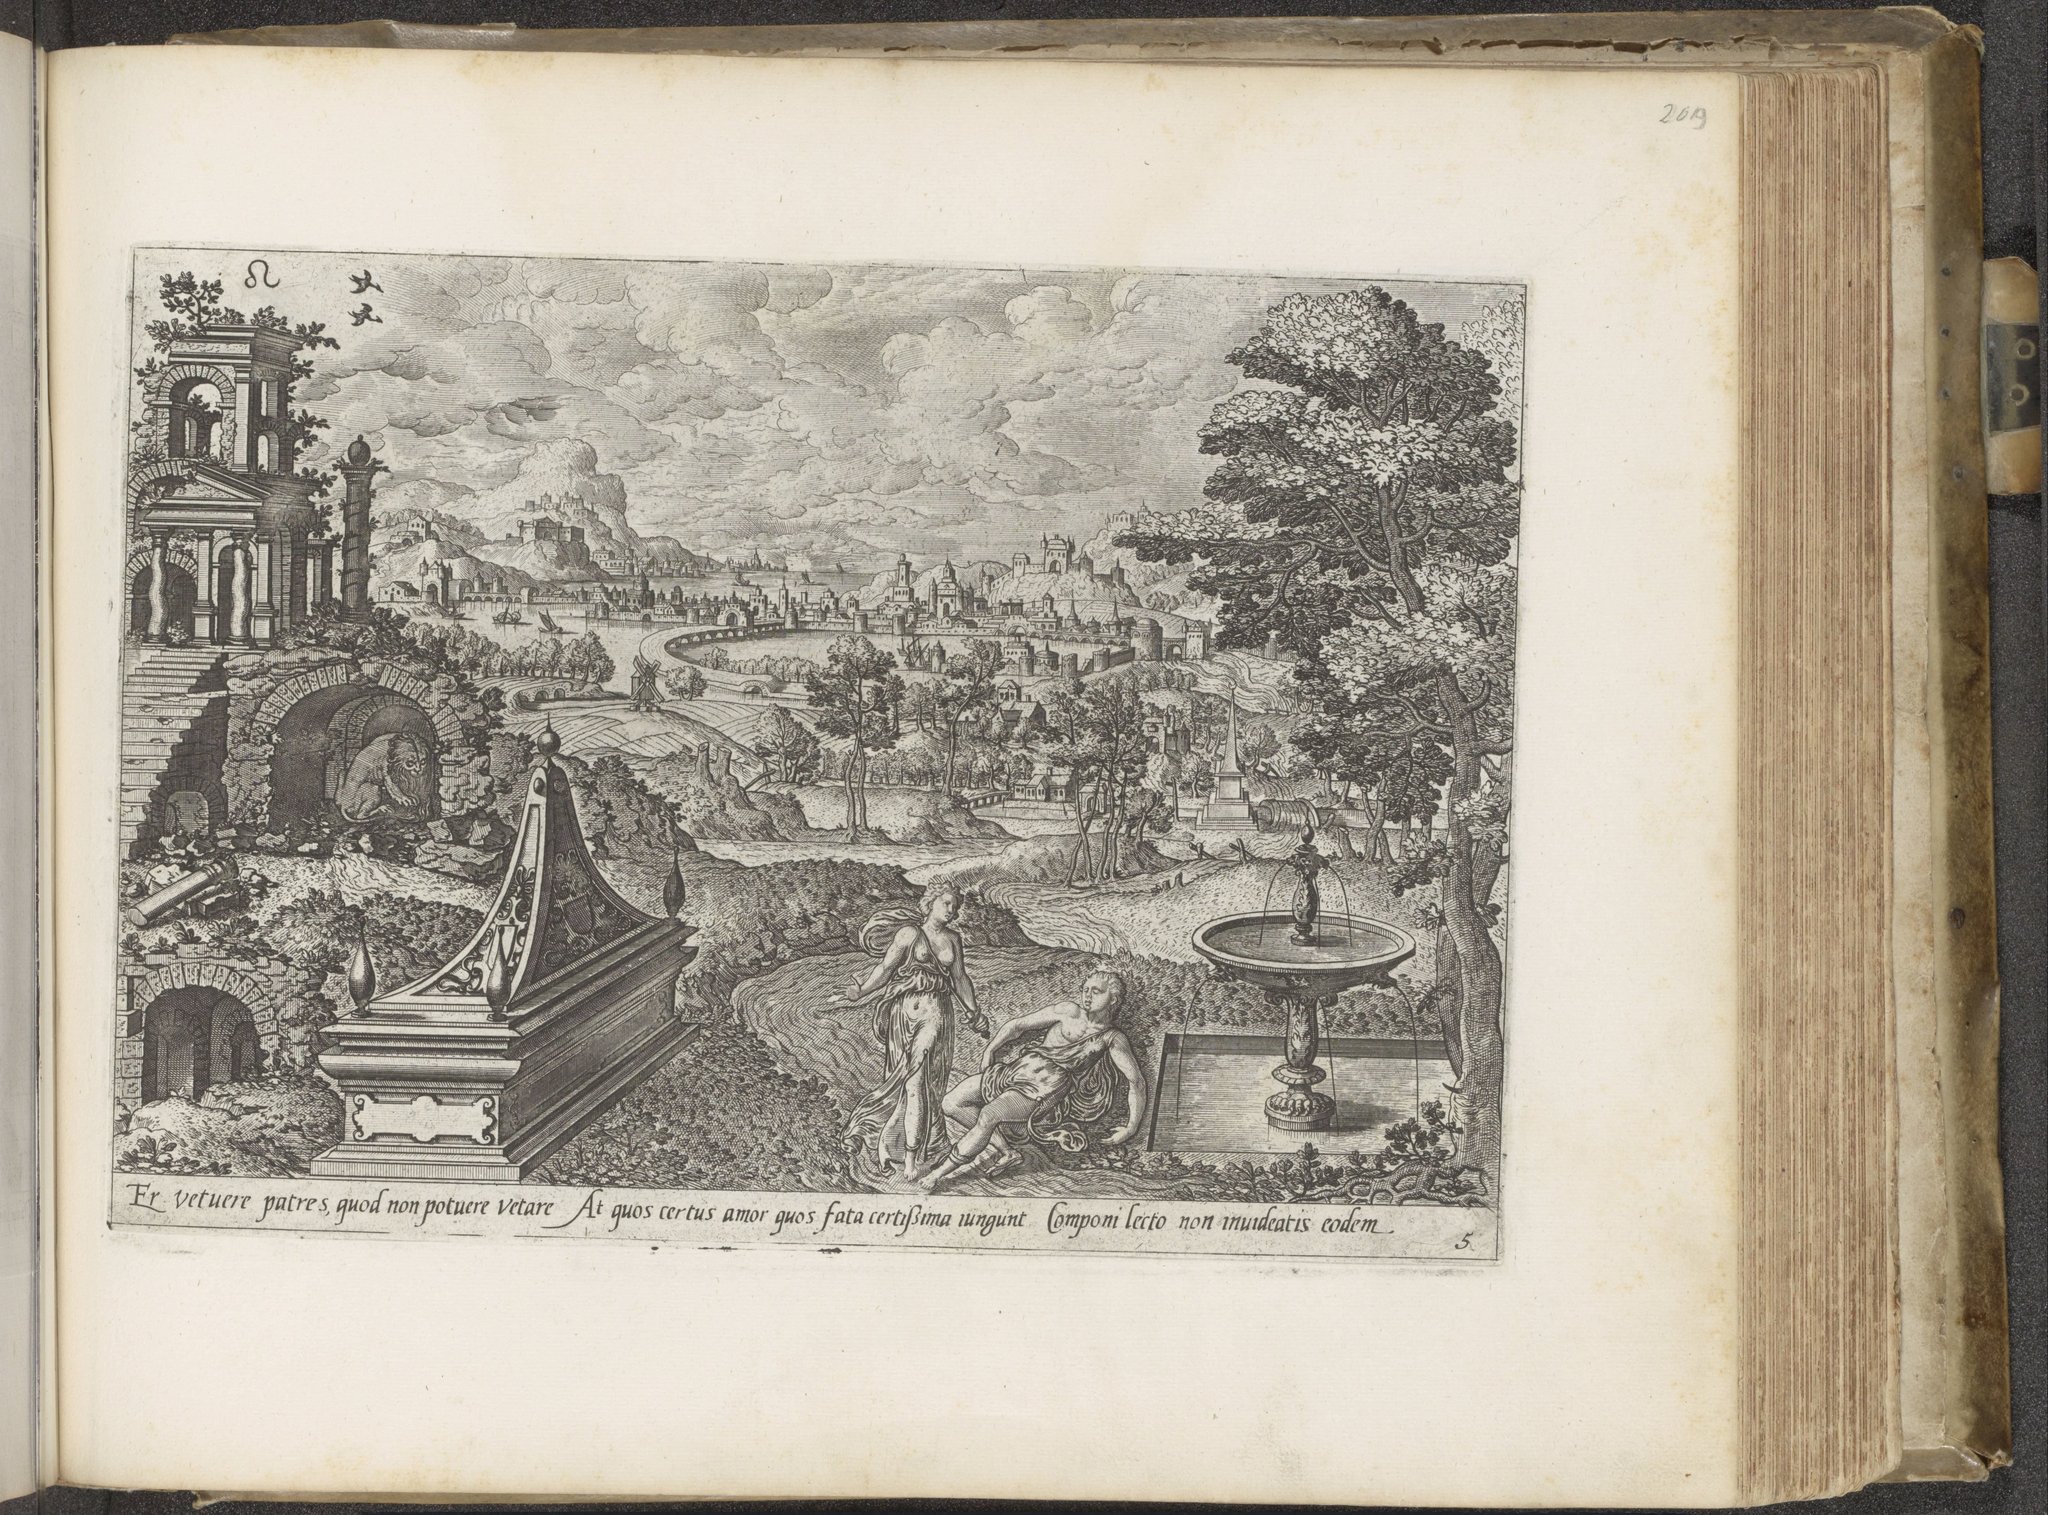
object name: print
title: Metamorfosen van Ovidius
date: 1653-1654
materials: paper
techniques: etching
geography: amsterdam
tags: landscapes, thisbe kills herself with pyramus' sword (the scene may be represented near a fountain)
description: Landschap met de dode Pyramus bij een fontein. Hij heeft zichzelf neergestoken, omdat hij dacht dat Thisbe door een leeuw was gedood. Thisbe ontdekt haar stervende geliefde, waarop zij zelfmoord pleegt met het zwaard van Pyramus. Links op de achtergrond zit de leeuw onder een stenen boog. Onder de voorstelling een verklarende tekst. De eerste regel uit de Metamorfosen van Ovidius, boek 4, versregel 61. Linksboven het teken van de Leeuw uit de dierenriem. De prent maakt deel uit van een album.